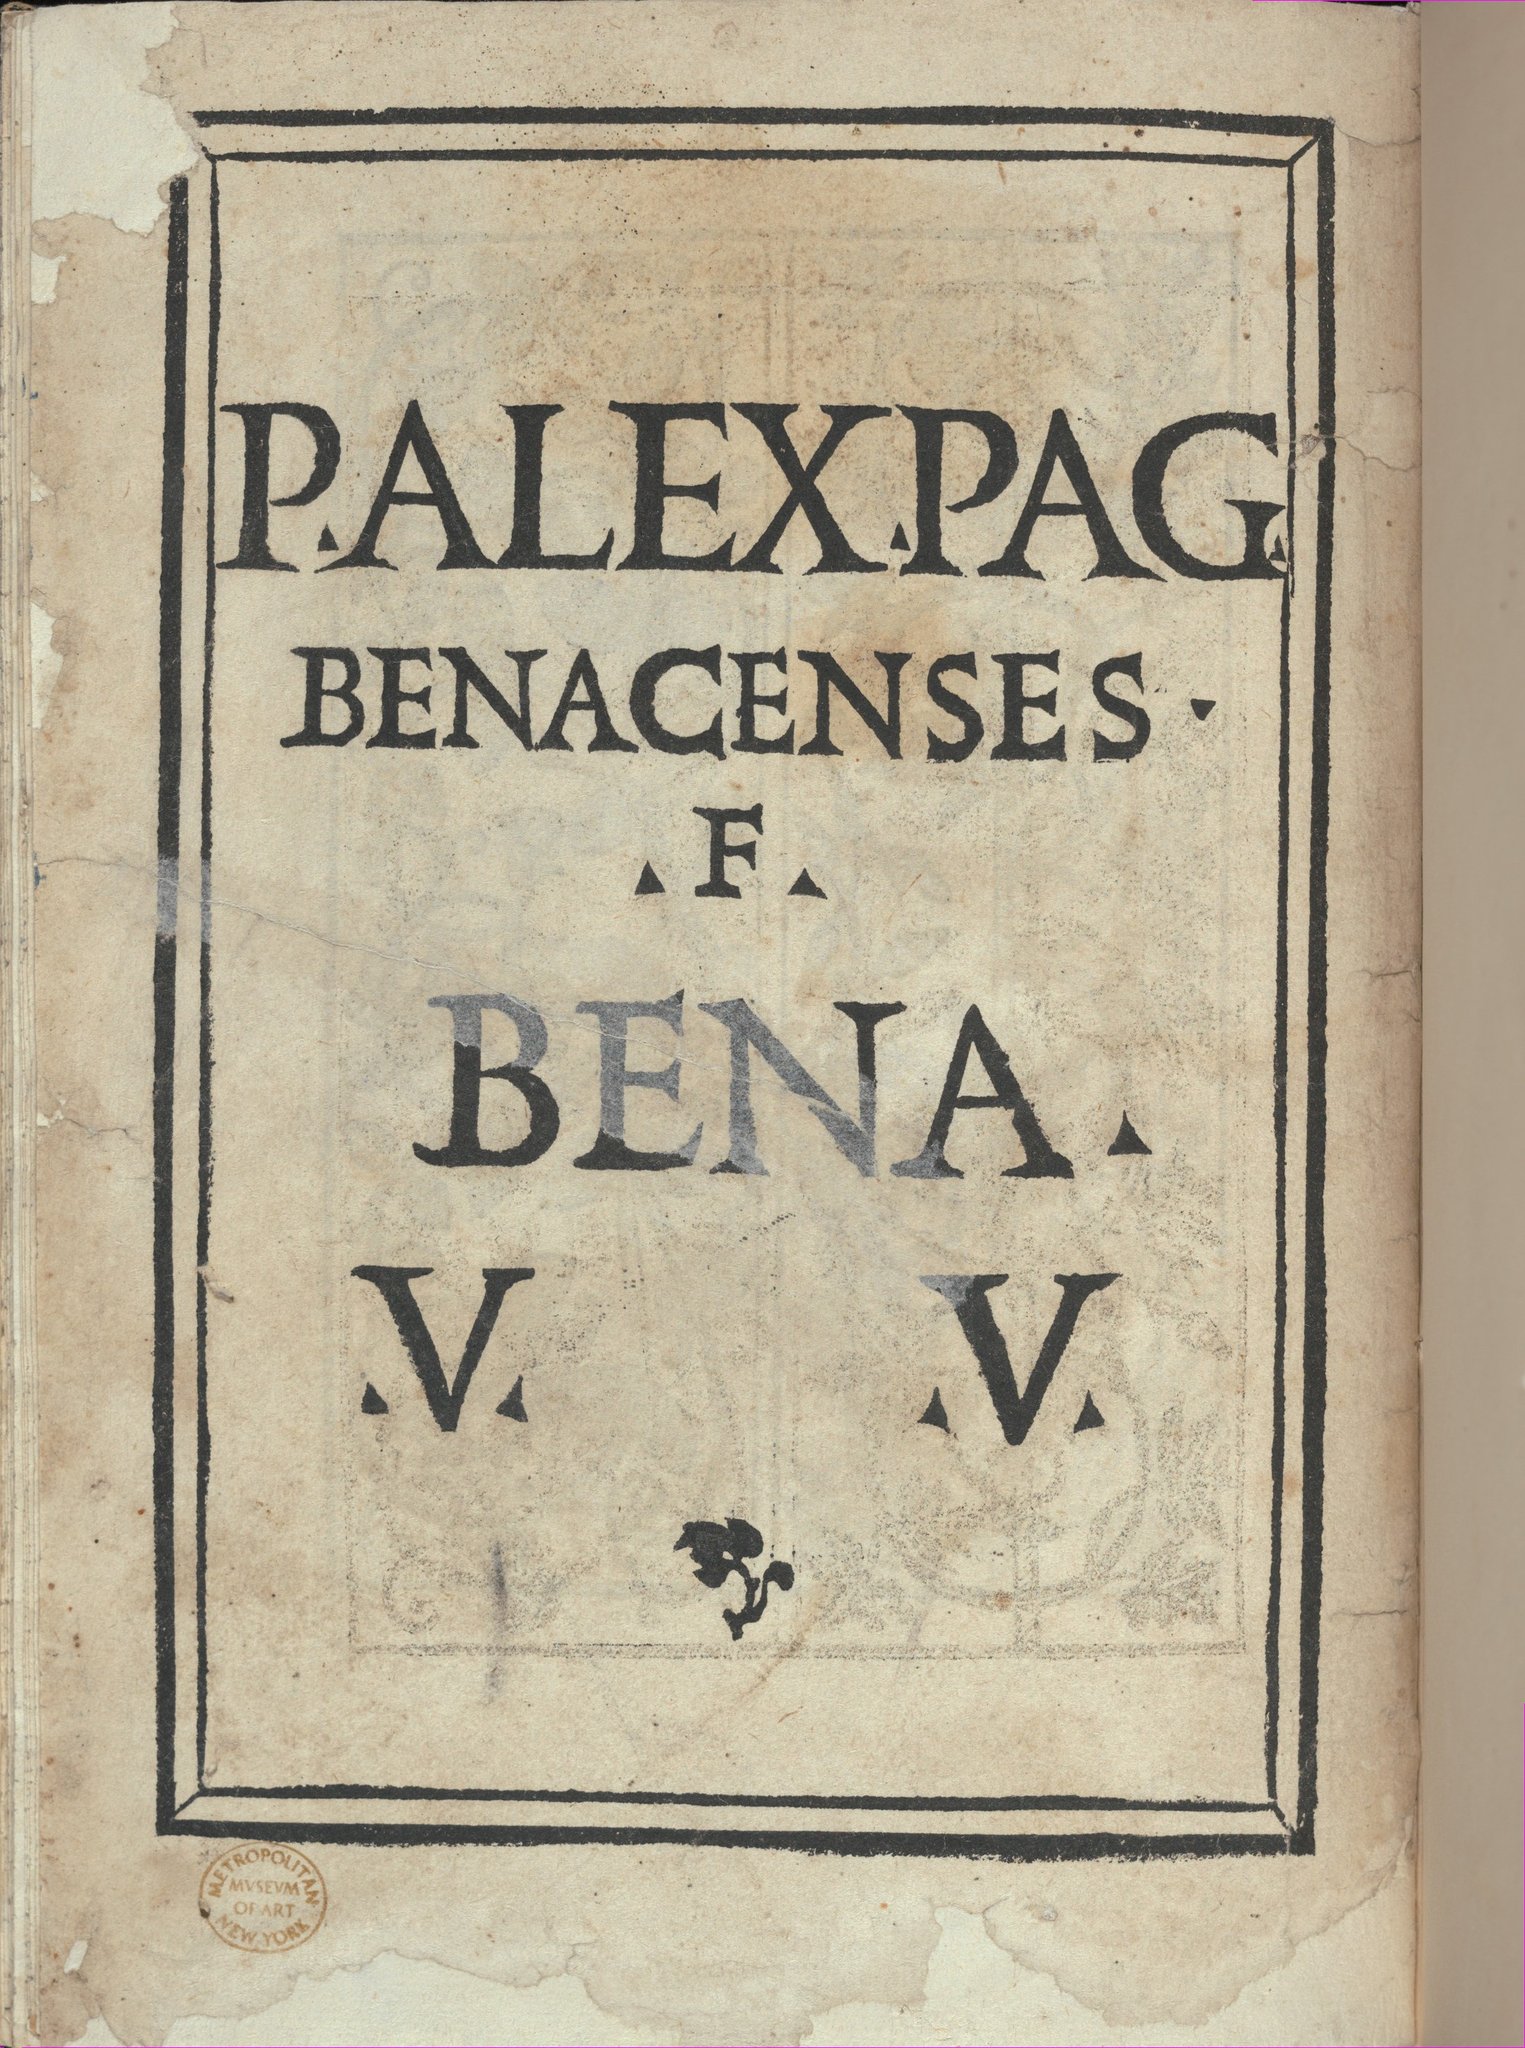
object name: book print ornament architecture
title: Libro quarto. De rechami per elquale se impara in diuersi modi lordine e il modo de recamare...Opera noua, page 18 (verso)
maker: alessandro paganino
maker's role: publisher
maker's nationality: italian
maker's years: 1500-1550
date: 1532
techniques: woodcut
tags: flowers